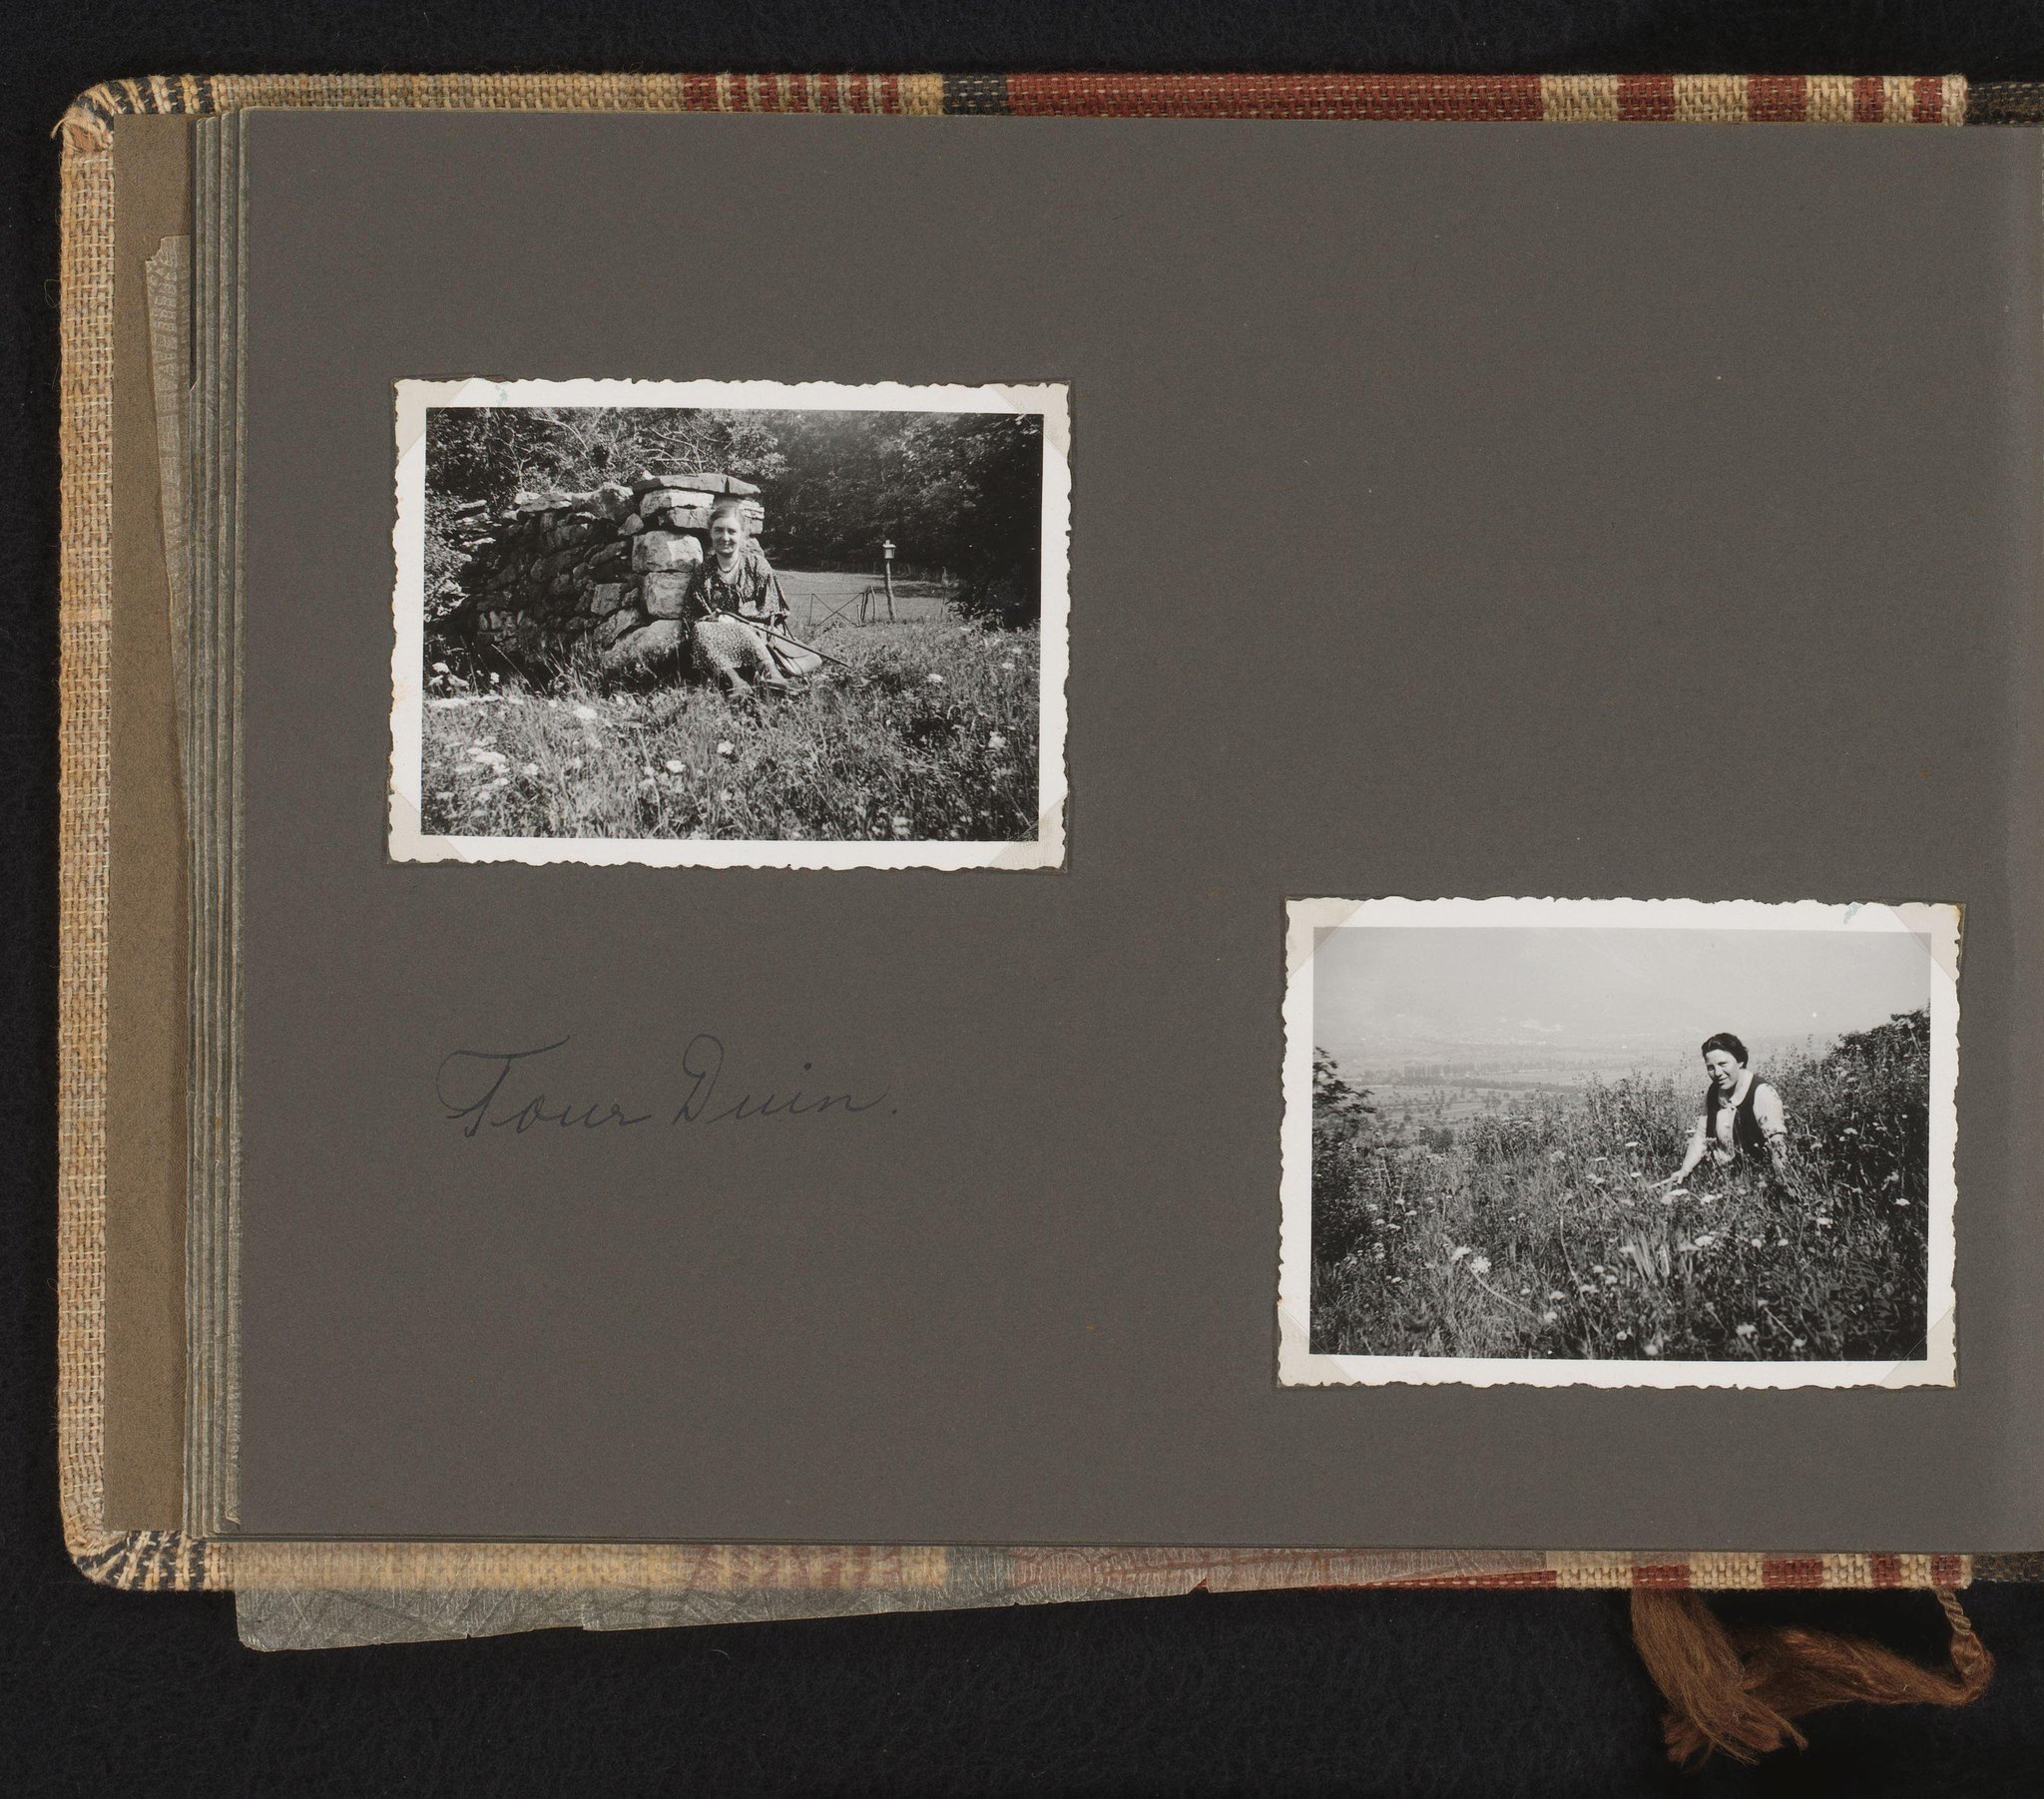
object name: photograph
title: Vrouwen in het gras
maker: Anonymous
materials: paper, photographic support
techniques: gelatin silver print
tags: adult woman, historical persons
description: Twee foto's van een vrouw in het gras in een heuvelachtig landschap met als onderschrift Tour Duin. Deze pagina is onderdeel van een album.